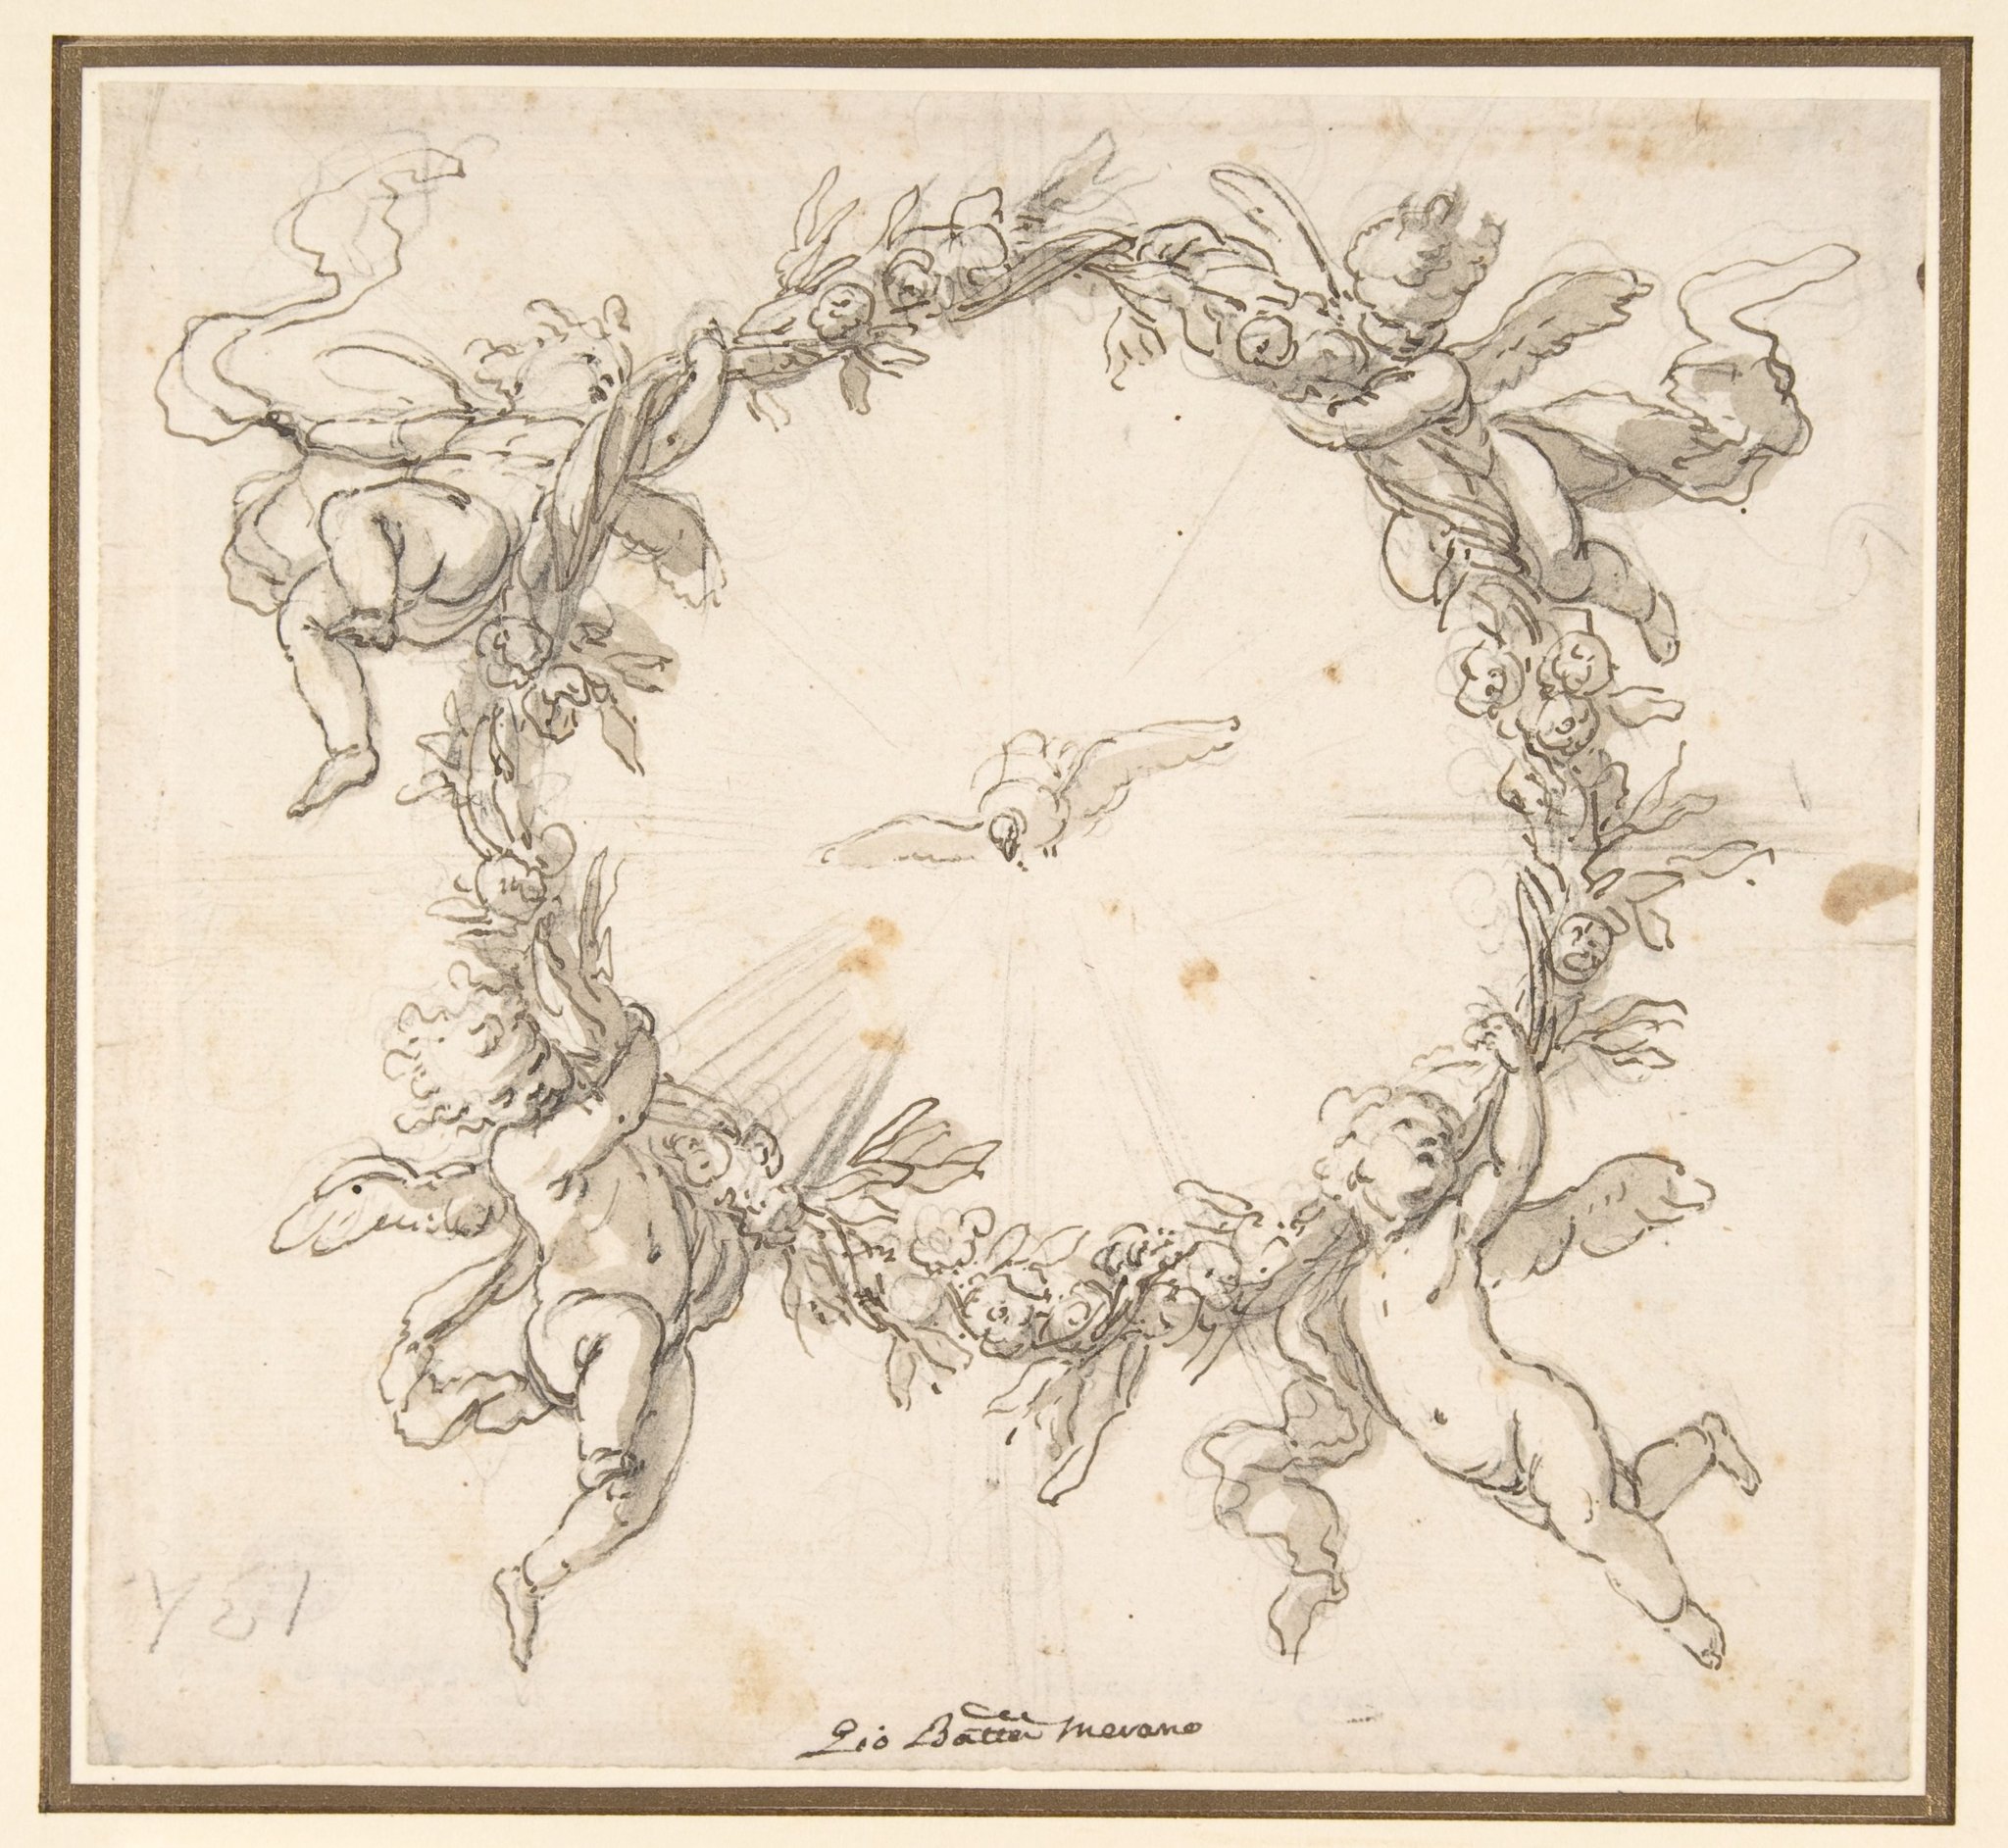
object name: drawing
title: The Holy Spirit Surrounded by a Wreath of Flowers Held up by Infant Angels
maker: giovanni battista merano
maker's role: artist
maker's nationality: italian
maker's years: 1632-1698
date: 1632-1698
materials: chalk, ink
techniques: brush, pen, wash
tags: wreaths,angels